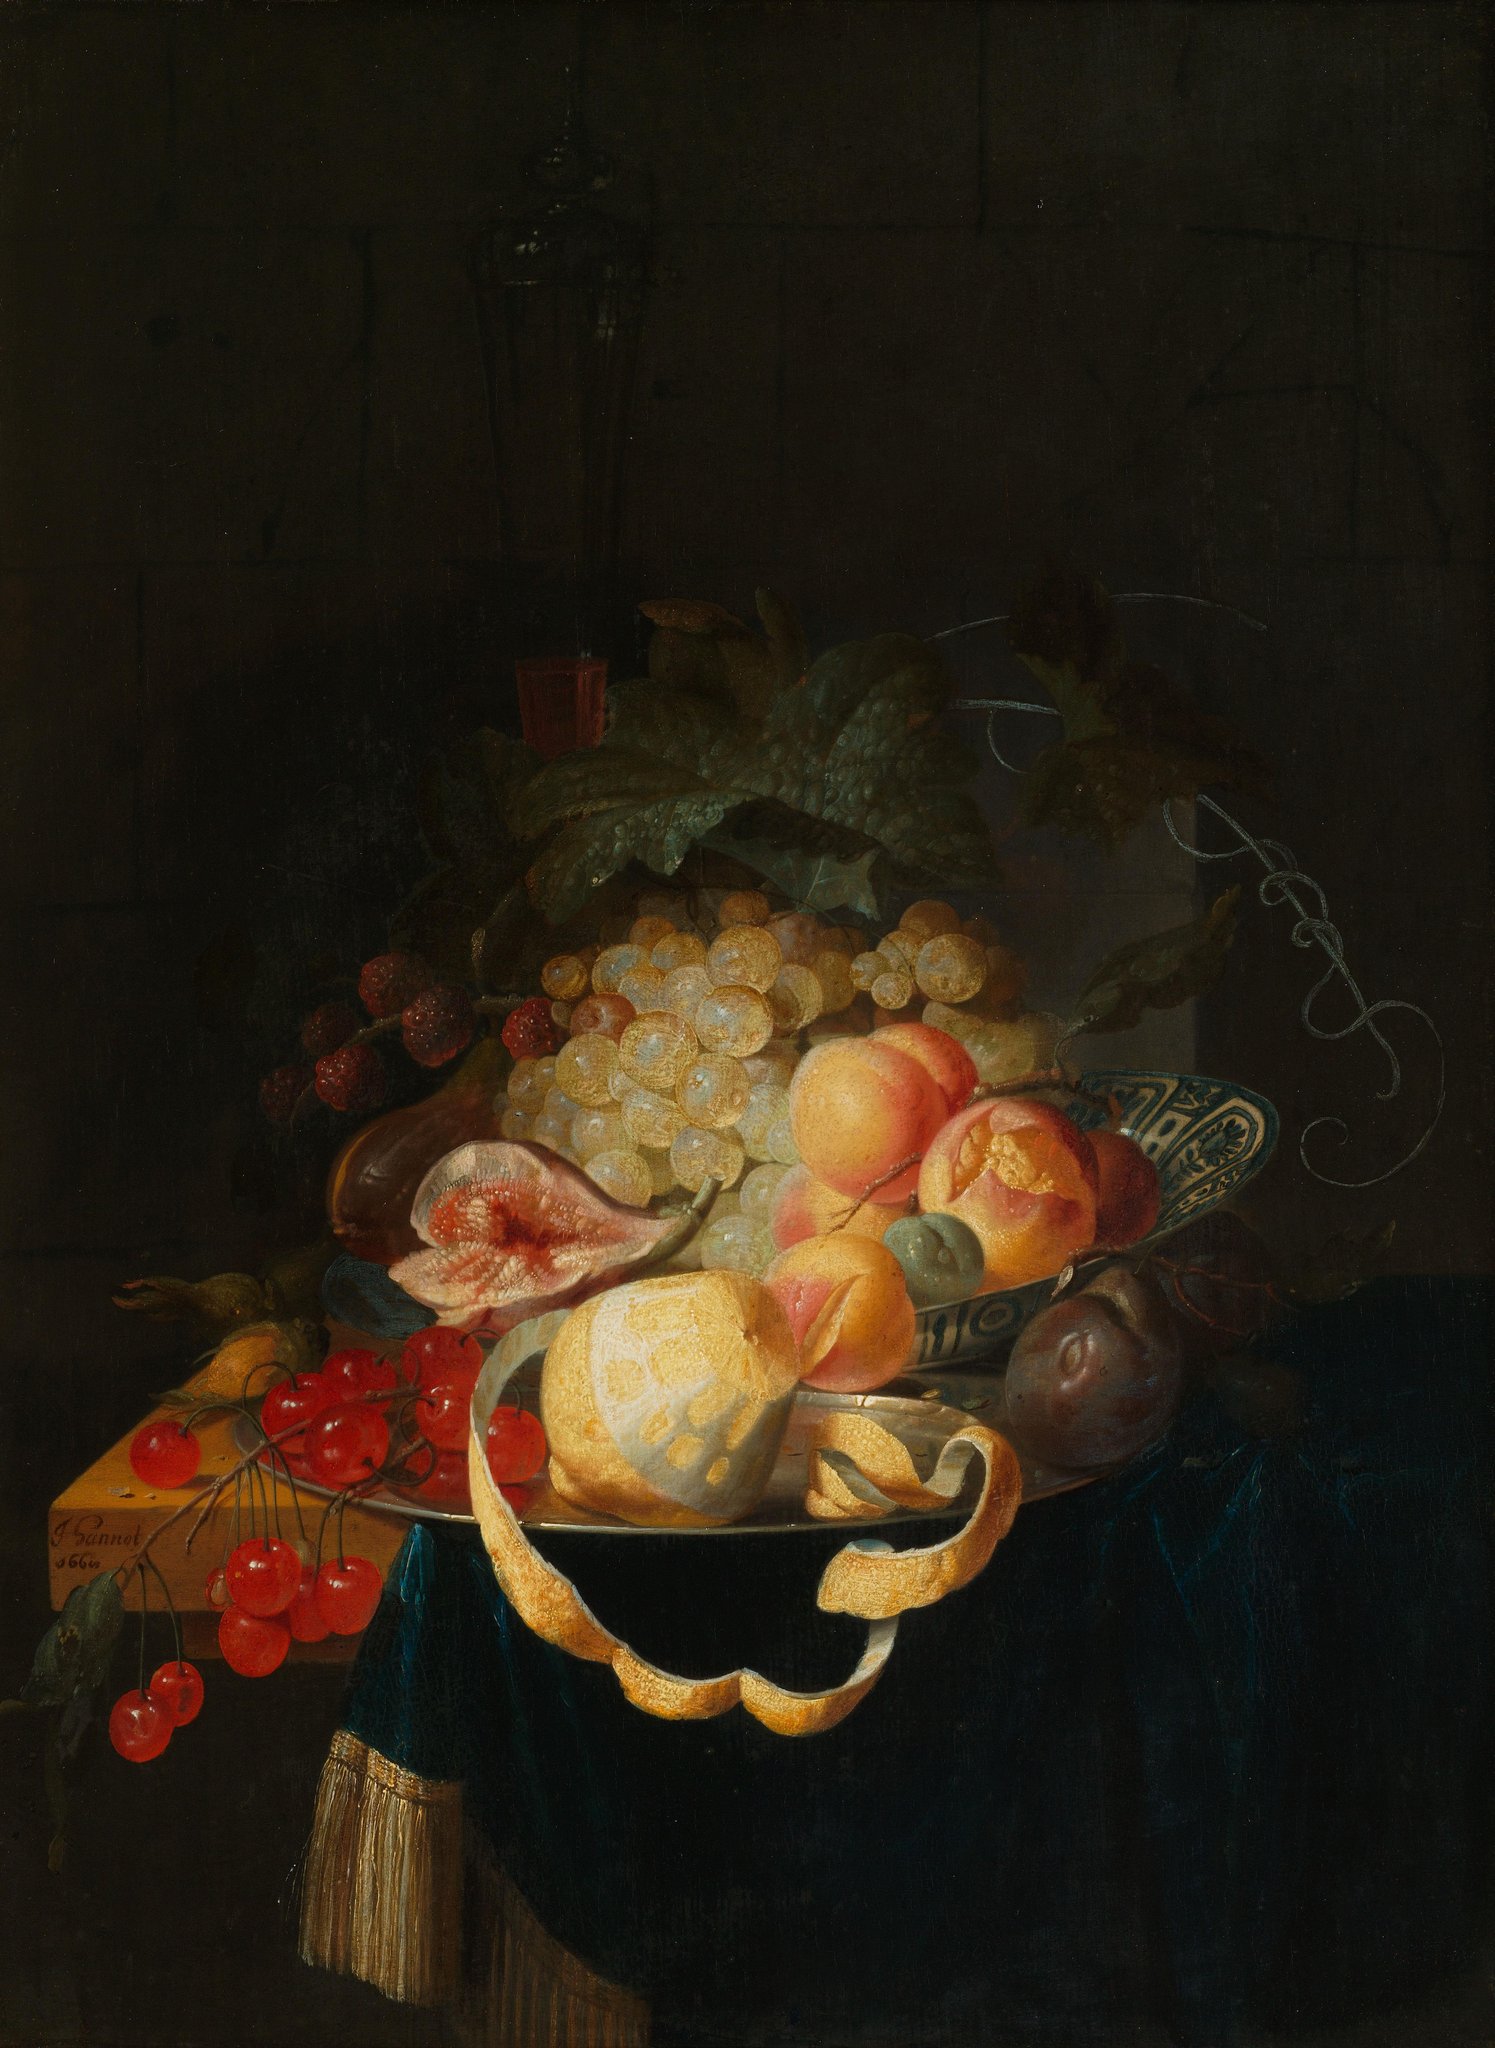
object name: painting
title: Still Life with Fruit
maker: johannes hannot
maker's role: painter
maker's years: 1633-1684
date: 1668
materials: oil, panel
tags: fruit, still life of related objects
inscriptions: signature and date: ‘J. Hannot 1668’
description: Stilleven met vruchten. Op de hoek van een tafel staat een tinnen bord waarop een geschilde citroen en een tak met kersen liggen, daarachter een Chinese kom met druiven, een vijg, perziken en pruimen.